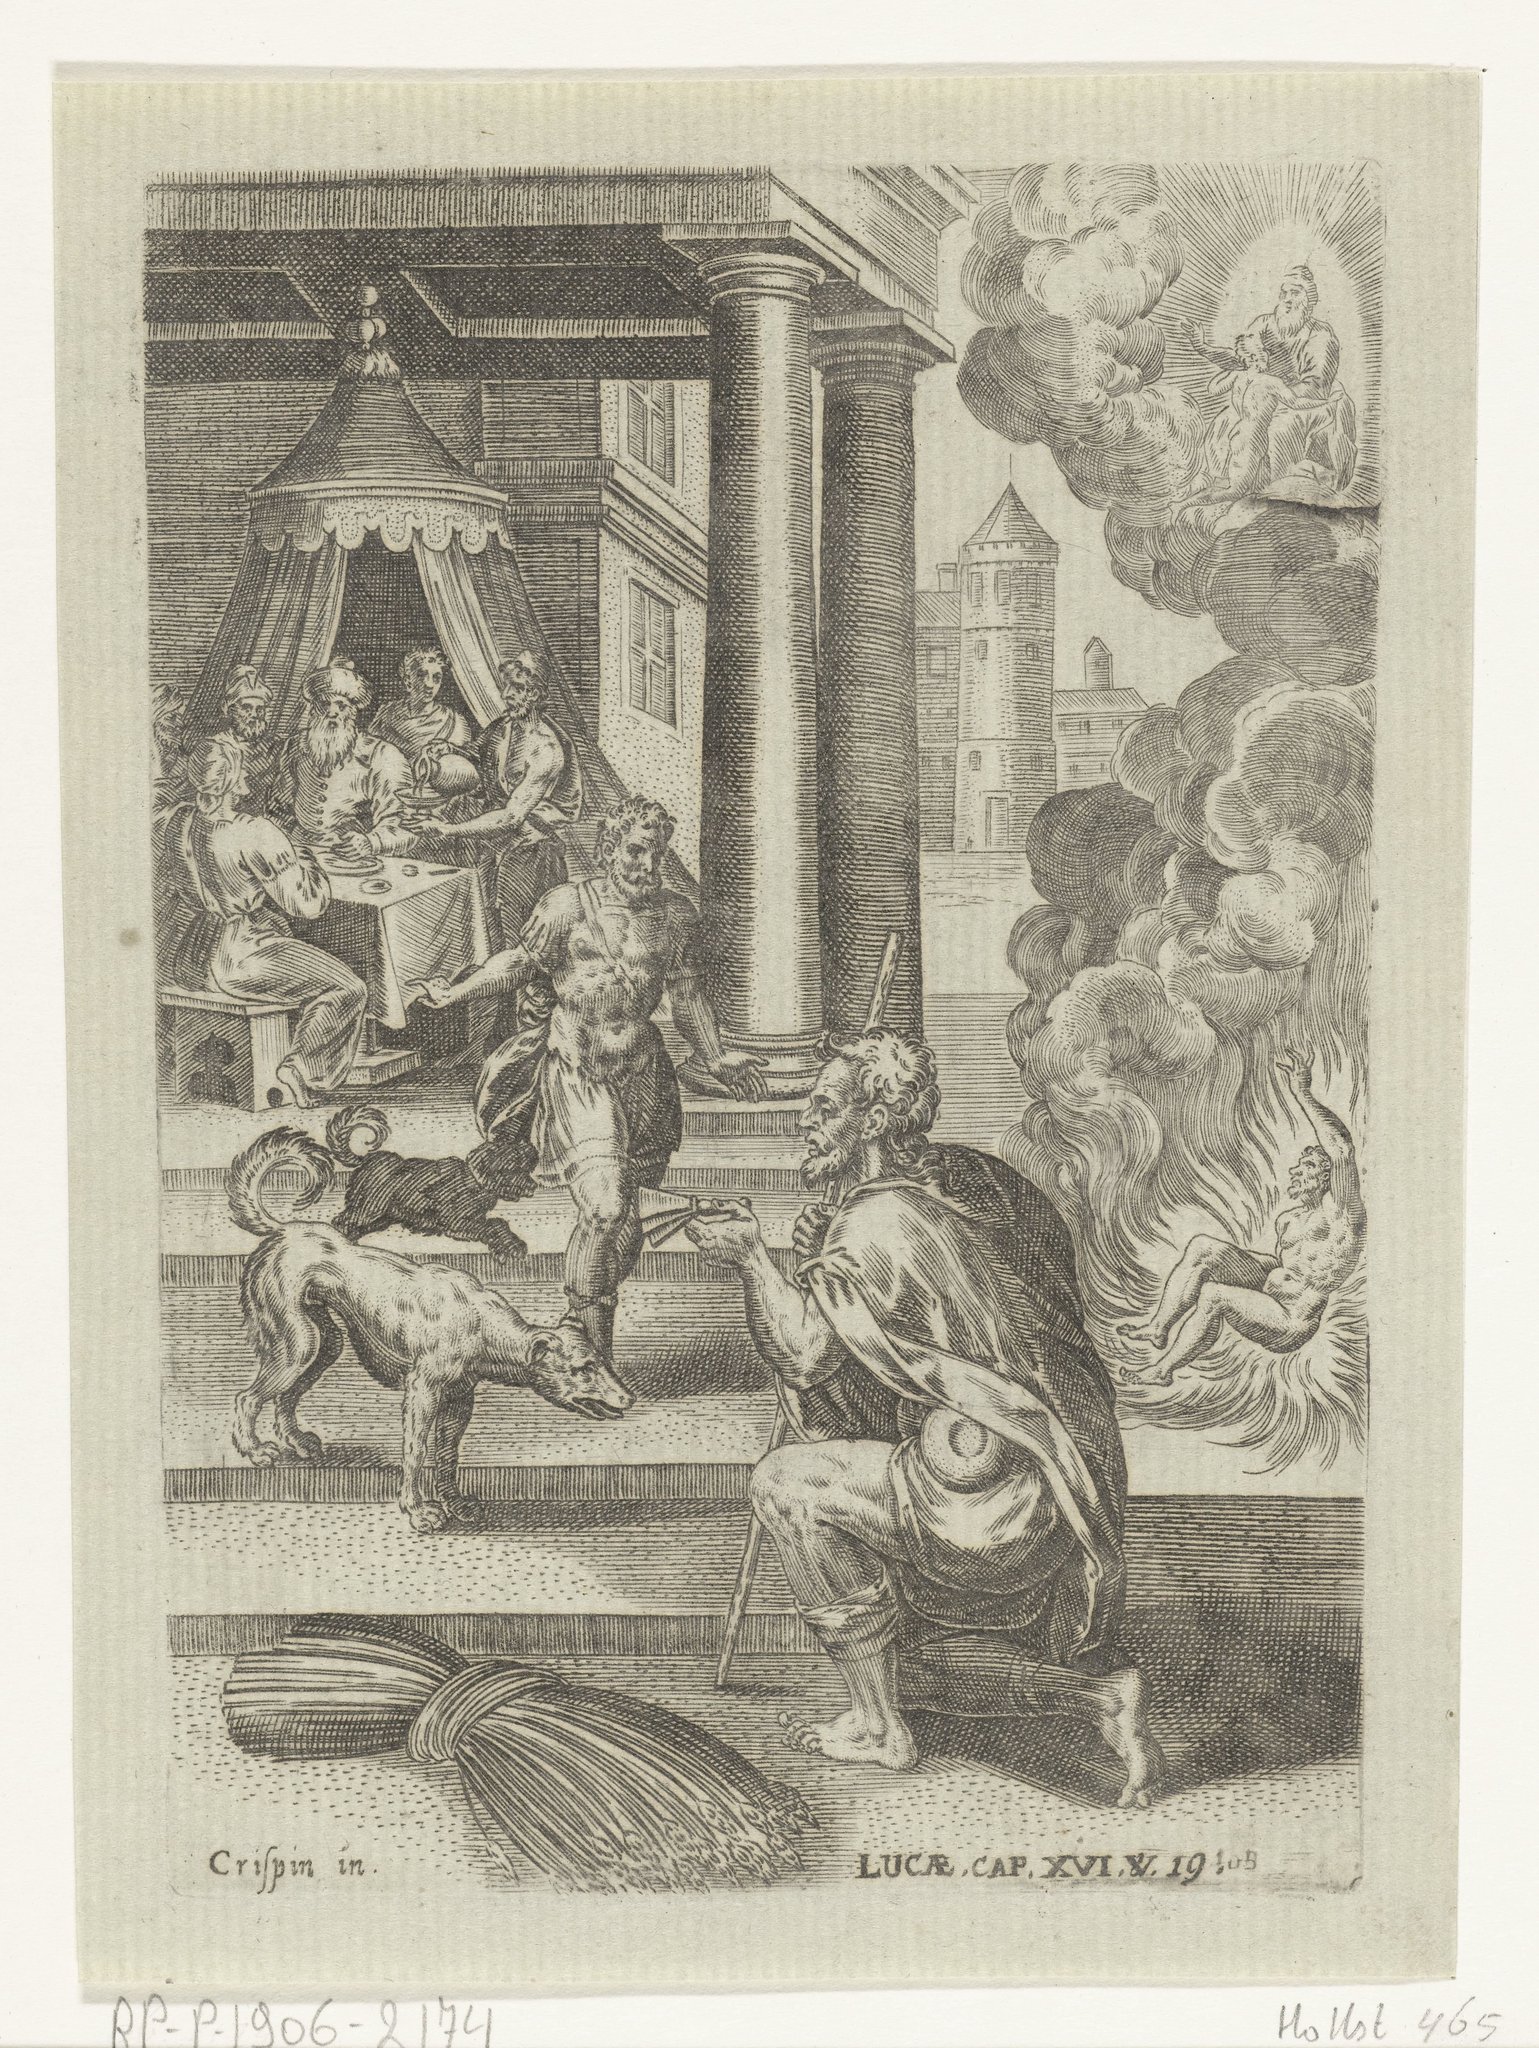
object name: print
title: Biblia sacra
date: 1583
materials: paper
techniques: engraving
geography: antwerp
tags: in hell dives sees lazarus in paradise; usually dives pointing at his tongue, lazarus' soul in abraham's bosom, the rich man (dives) is feasting, while poor lazarus is starving at the gate (dogs licking lazarus' sores) (luke 16:19-31)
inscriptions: collector's mark: Lugt 2228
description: Boekillustratie bij de parabel van Lazarus en de rijke man (Lucas 16:19-31). De bedelaar Lazarus knielt voor het huis van een rijke man. Hij smeekt om wat eten. De rijke man stuurt slechts zijn twee honden naar hem toe om de man zijn zweren te likken. Als beiden sterven komt Lazarus in de hemel terecht, terwijl de rijke man in de hel moet branden. Hoewel de rijke man smeekt om hulp, wordt dit hem afgewezen. Hij had hulp moeten bieden in zijn levenstijd. De prent bevat een onderschrift met een verwijzing naar de bijhorende Bijbelpassage.